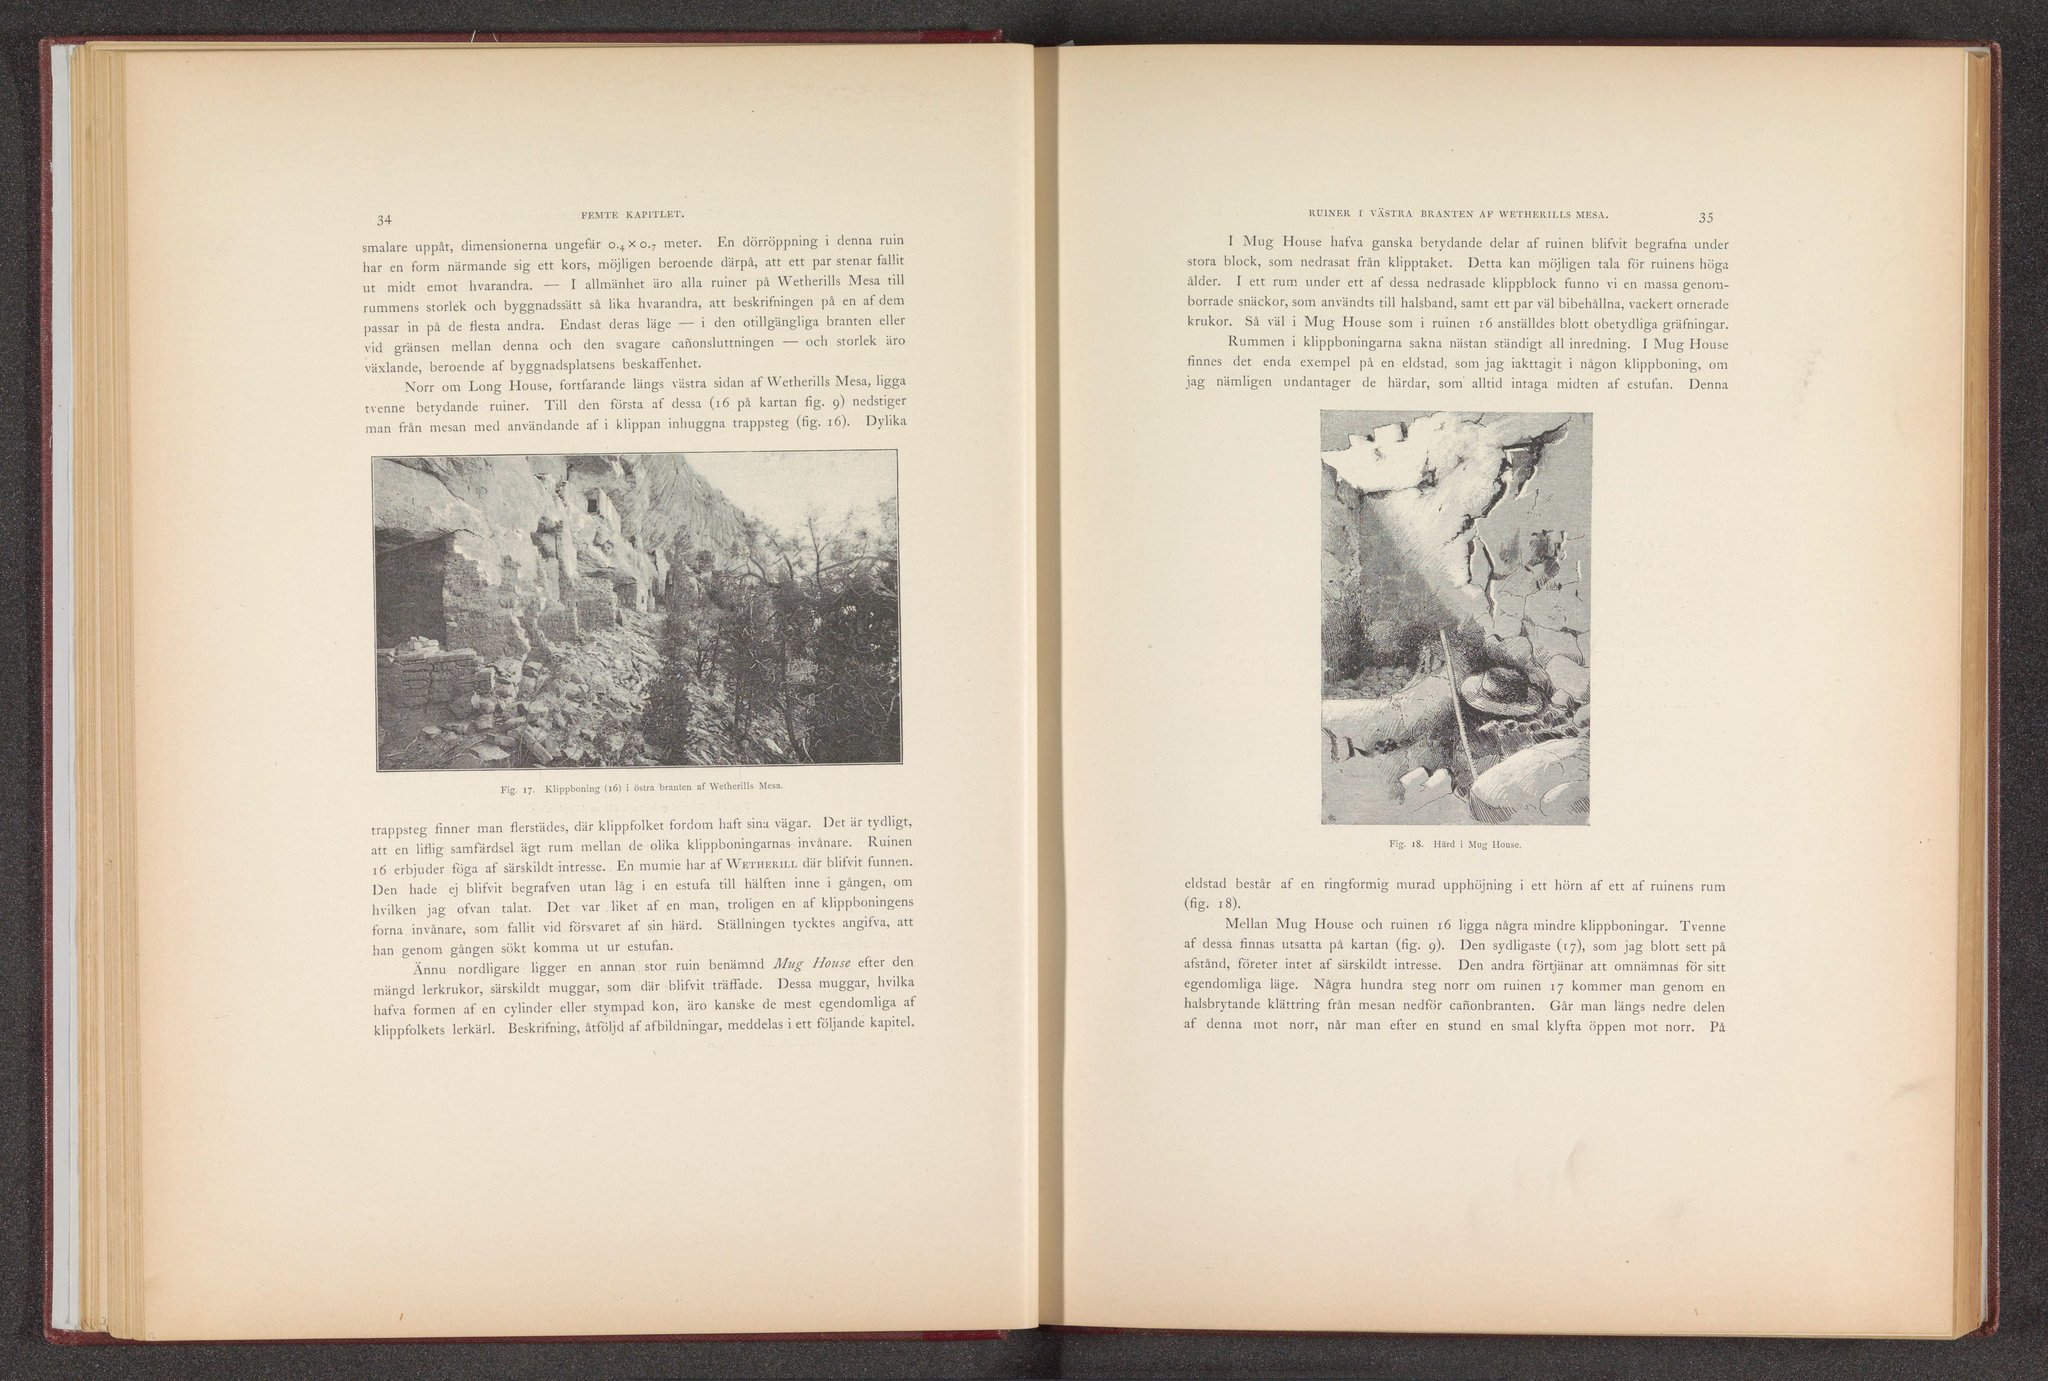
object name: photomechanical print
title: Gezicht op de ruïne van een rotswoning in Mesa Verde National Park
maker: gustaf nordenskiöld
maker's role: fotograaf, schrijver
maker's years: 1868-1895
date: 1891-1893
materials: paper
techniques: autotype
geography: vienna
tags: cave-dwelling, ruin of a dwelling, house, castle, etc.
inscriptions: number: ‘Fig. 17.’